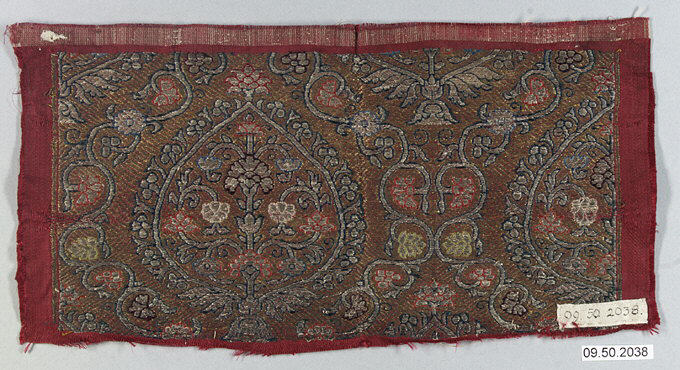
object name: textile fragment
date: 1801-1900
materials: metal thread, silk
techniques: brocade, satin weave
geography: india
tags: flowers